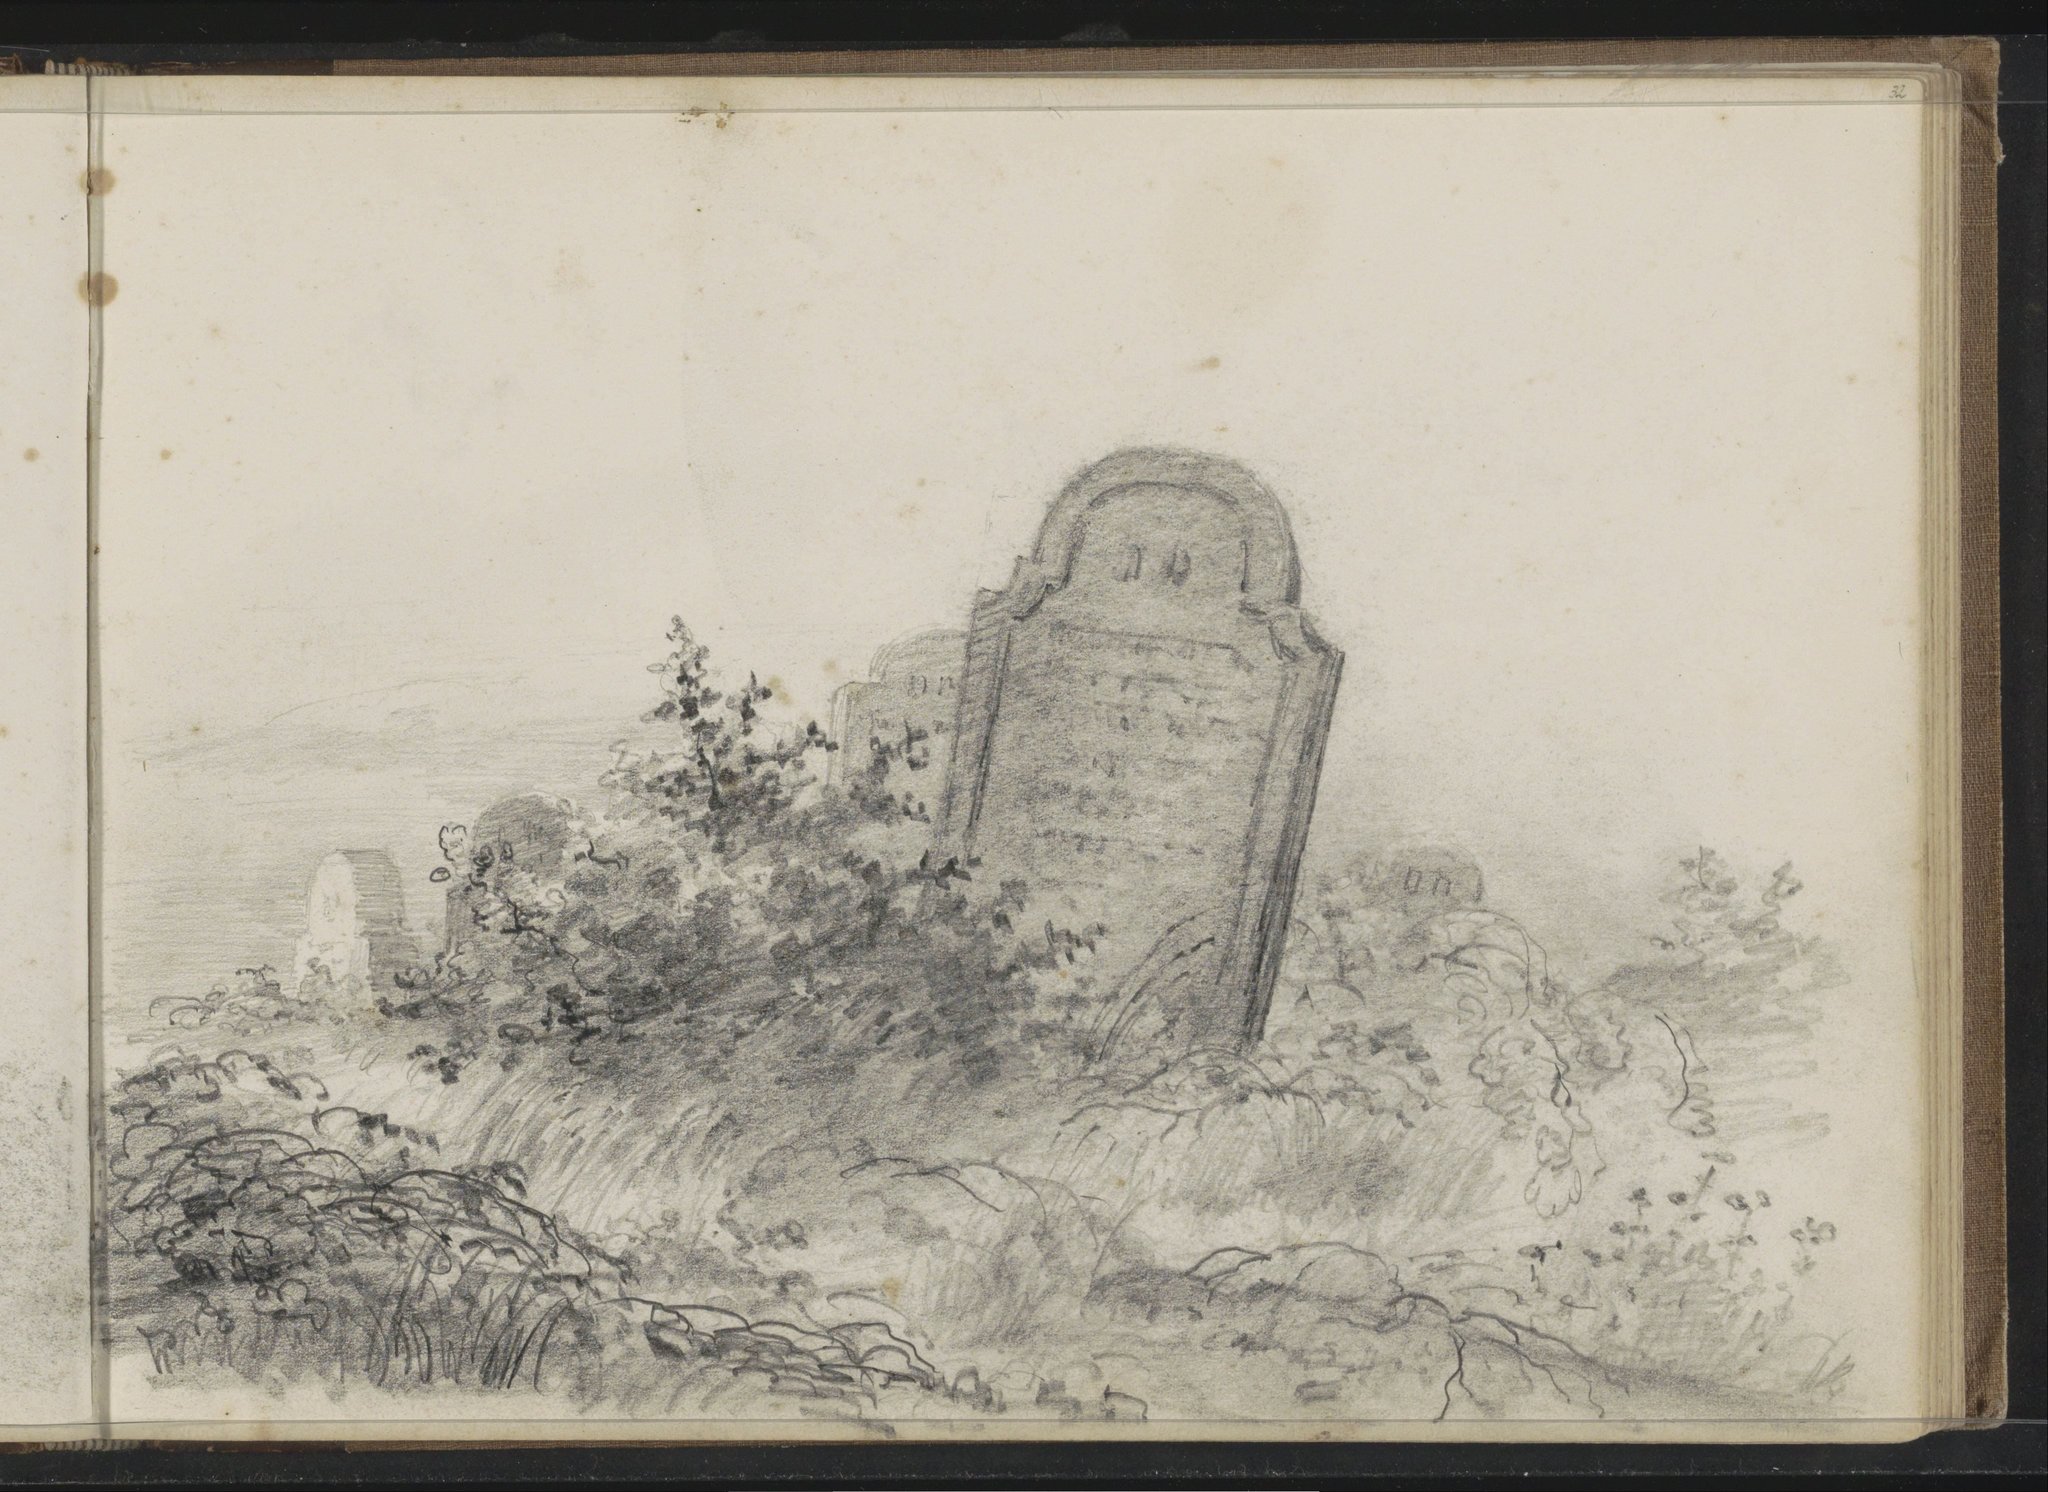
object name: sketchbook leaf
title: Grafstenen langs een pad in een landschap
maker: hendrik valkenburg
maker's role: draughtsman, painter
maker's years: 1826-1896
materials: paper, pencil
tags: upright gravestone, landscapes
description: Blad 32 recto uit een schetsboek met 77 bladen.